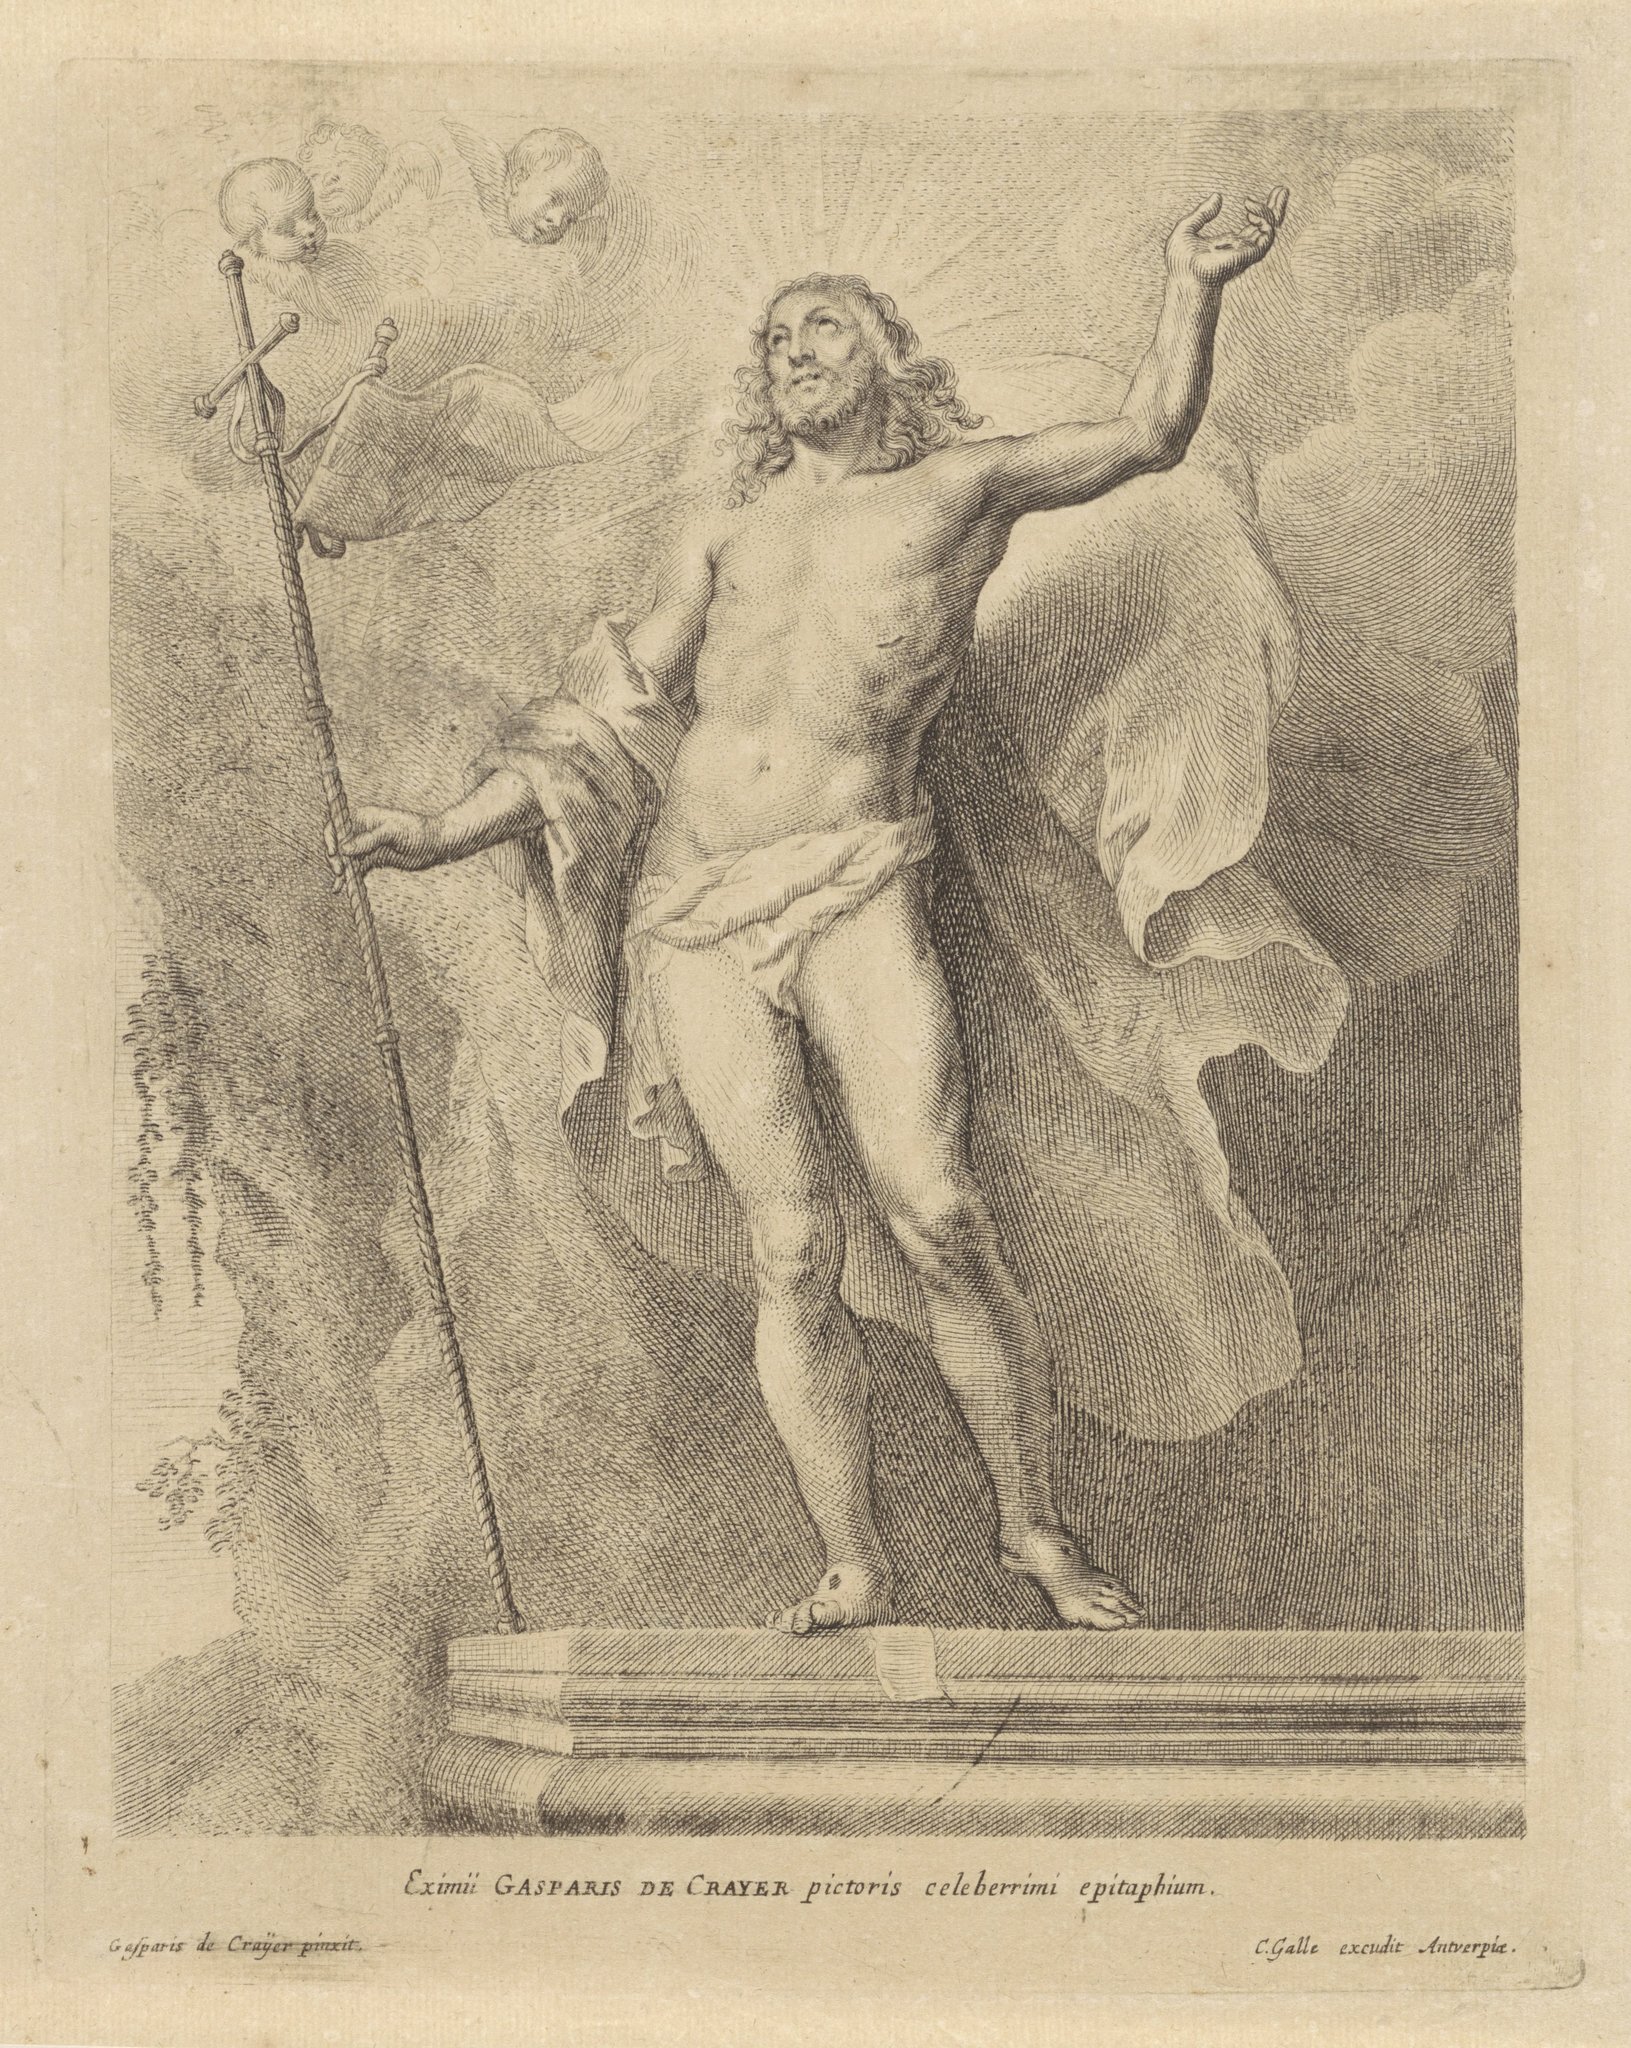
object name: print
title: Opstanding van Christus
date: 1669-1678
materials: paper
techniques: engraving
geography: antwerp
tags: christ, usually holding a banner, arises from the grave; often combined with sleeping and/or frightened soldiers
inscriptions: collector's mark: Lugt 2228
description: De verrezen Christus staat op zijn graftombe. Hij kijkt omhoog en houdt een kruis met een banier in zijn rechterhand. Boven de staf zijn drie Cherubijnen te zien. In de marge een éénregelig, lovend onderschrift over de overleden schilder in het Latijn.